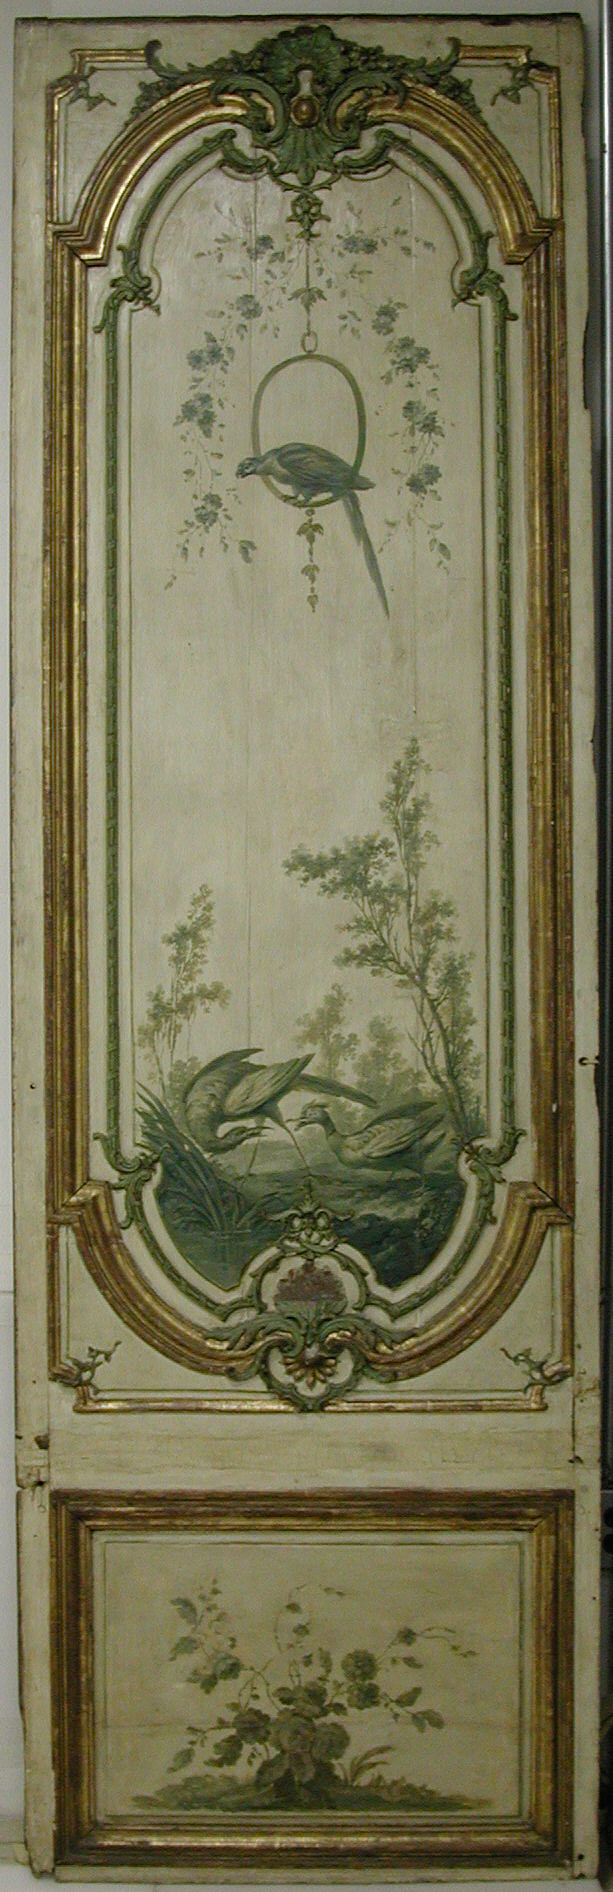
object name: door panel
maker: jean-baptiste oudry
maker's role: artist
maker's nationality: french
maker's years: 1686-1755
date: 1701-1800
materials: wood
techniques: gilding, painting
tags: birds,flowers,leaves